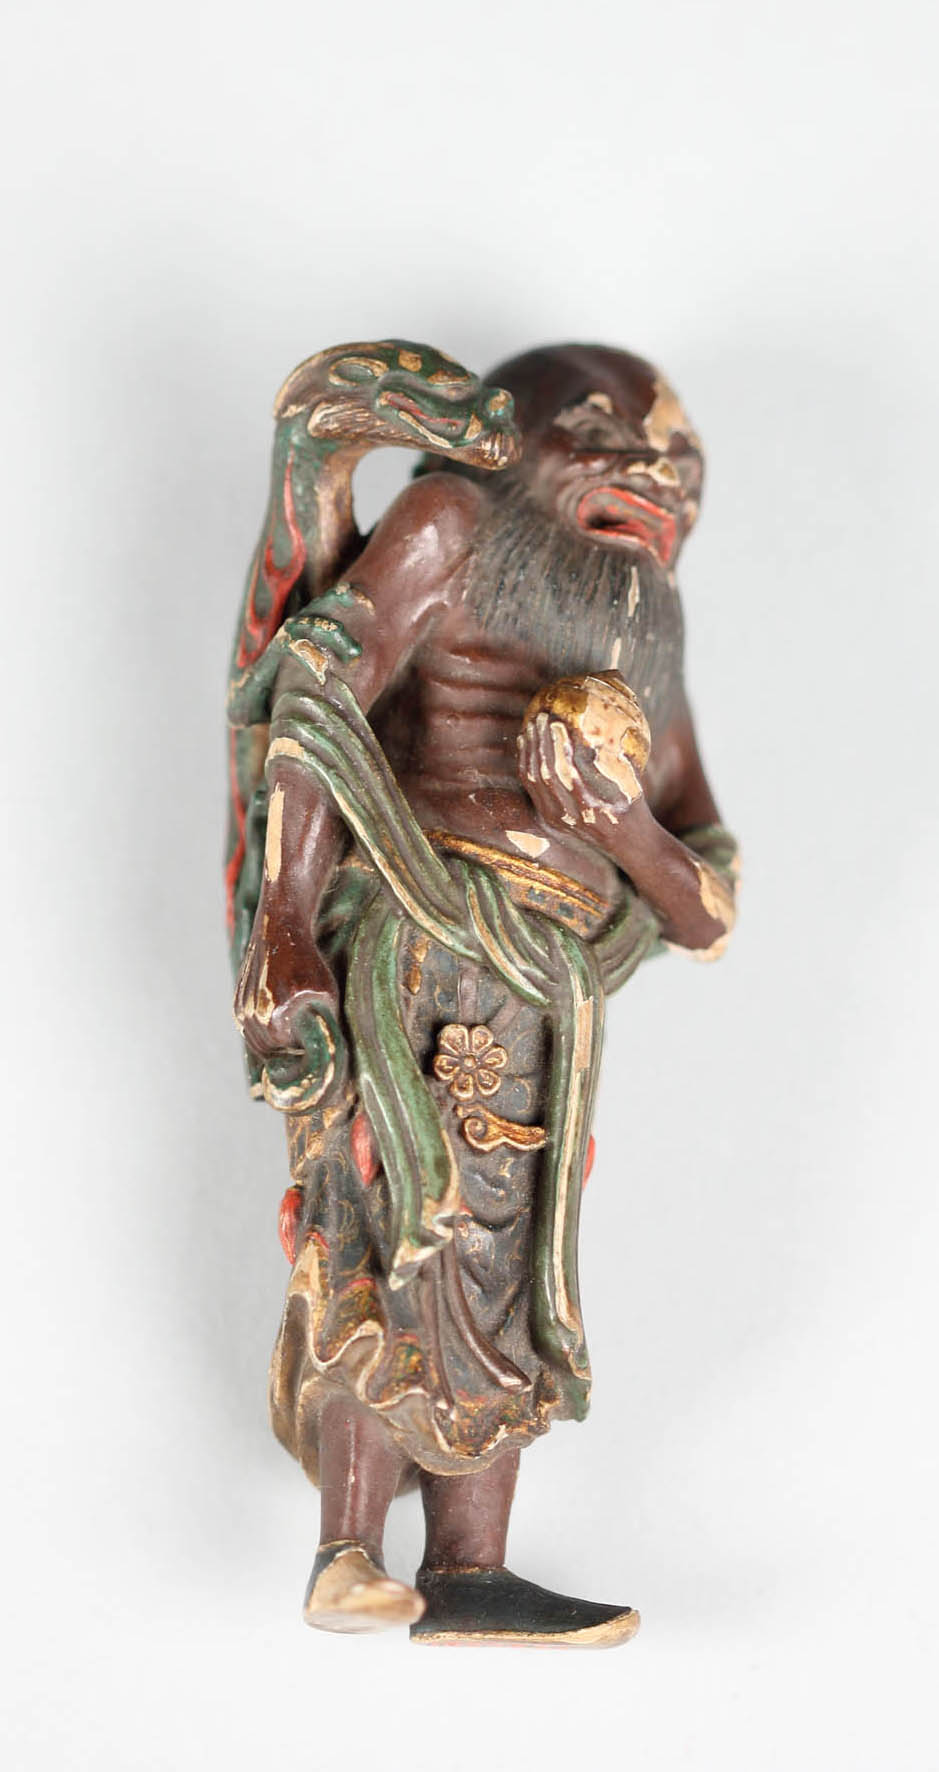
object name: netsuke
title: Netsuke of an Arhat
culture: japanese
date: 1801-1900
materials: wood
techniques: polychrome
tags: men